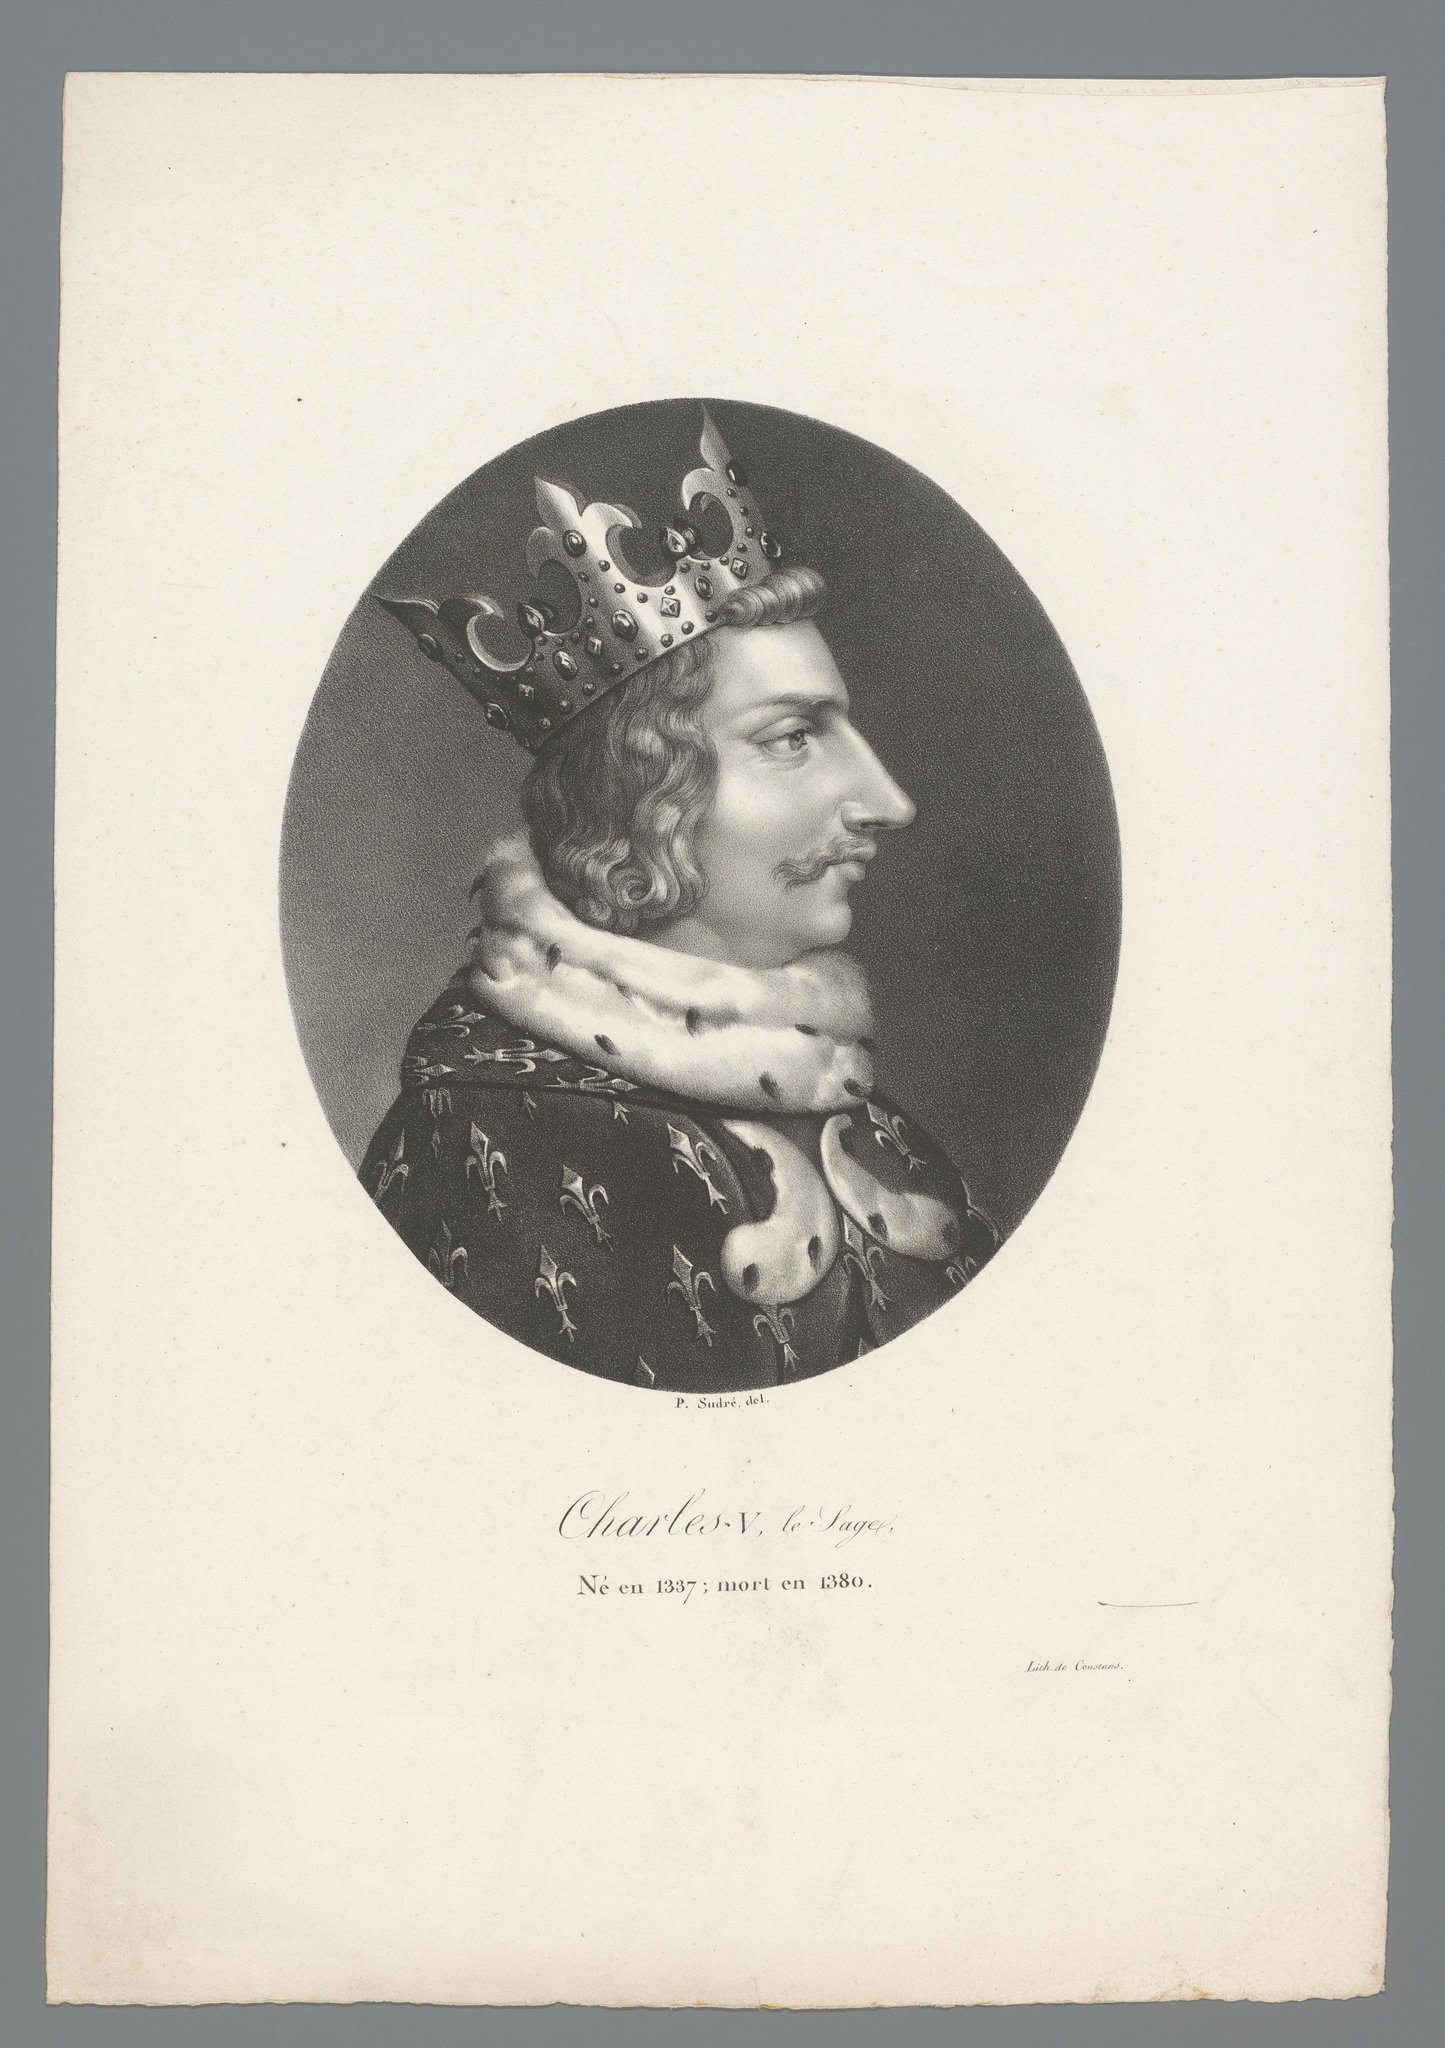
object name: print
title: Le panthéon français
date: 1824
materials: paper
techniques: lithograph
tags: historical persons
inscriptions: collector's mark: Lugt 2228